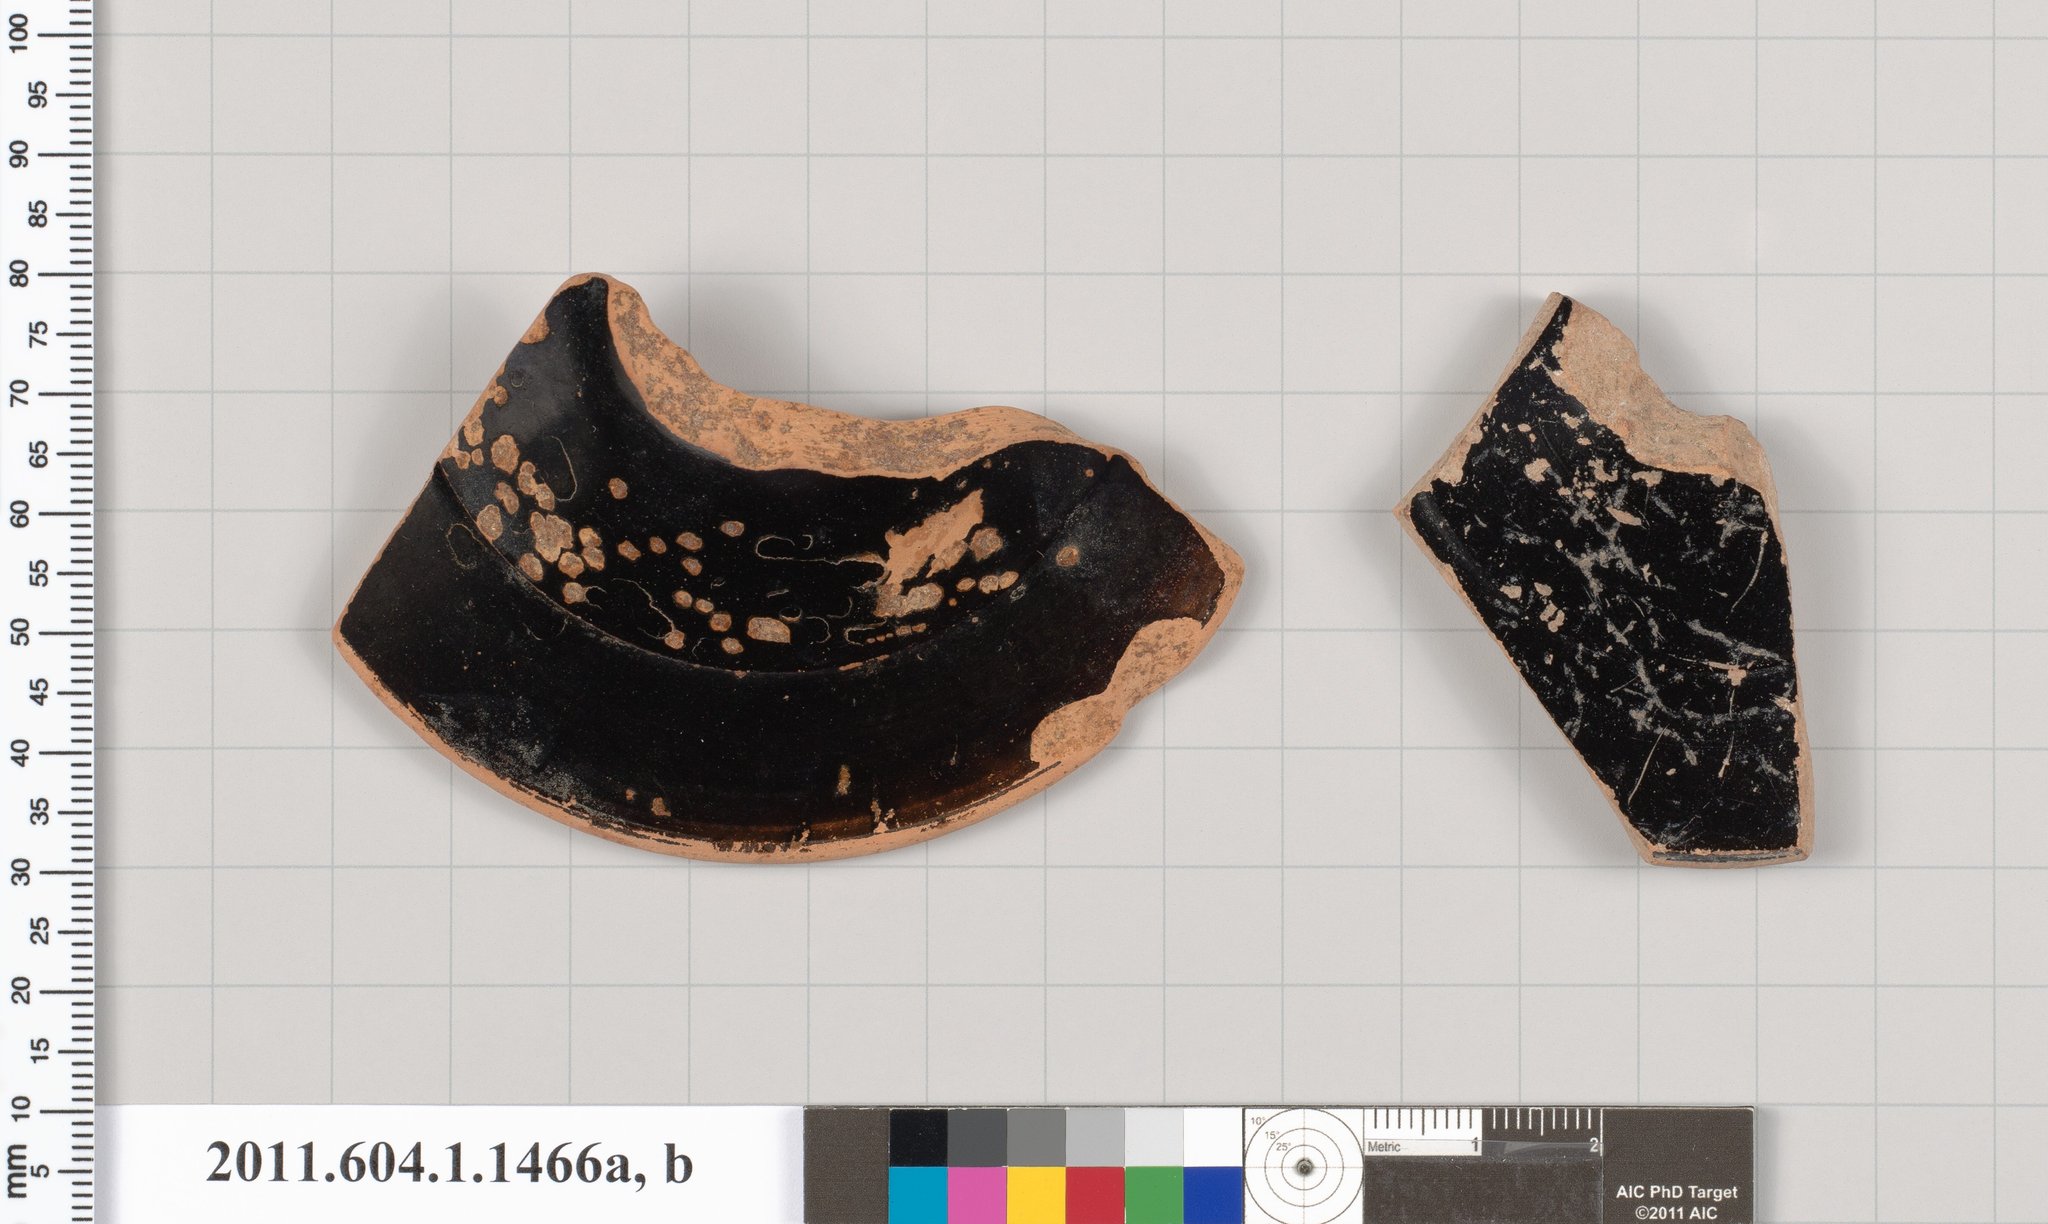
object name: kylix fragment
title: Terracotta fragments of kylikes (drinking cups)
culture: greek, attic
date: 500-401 BCE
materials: terracotta